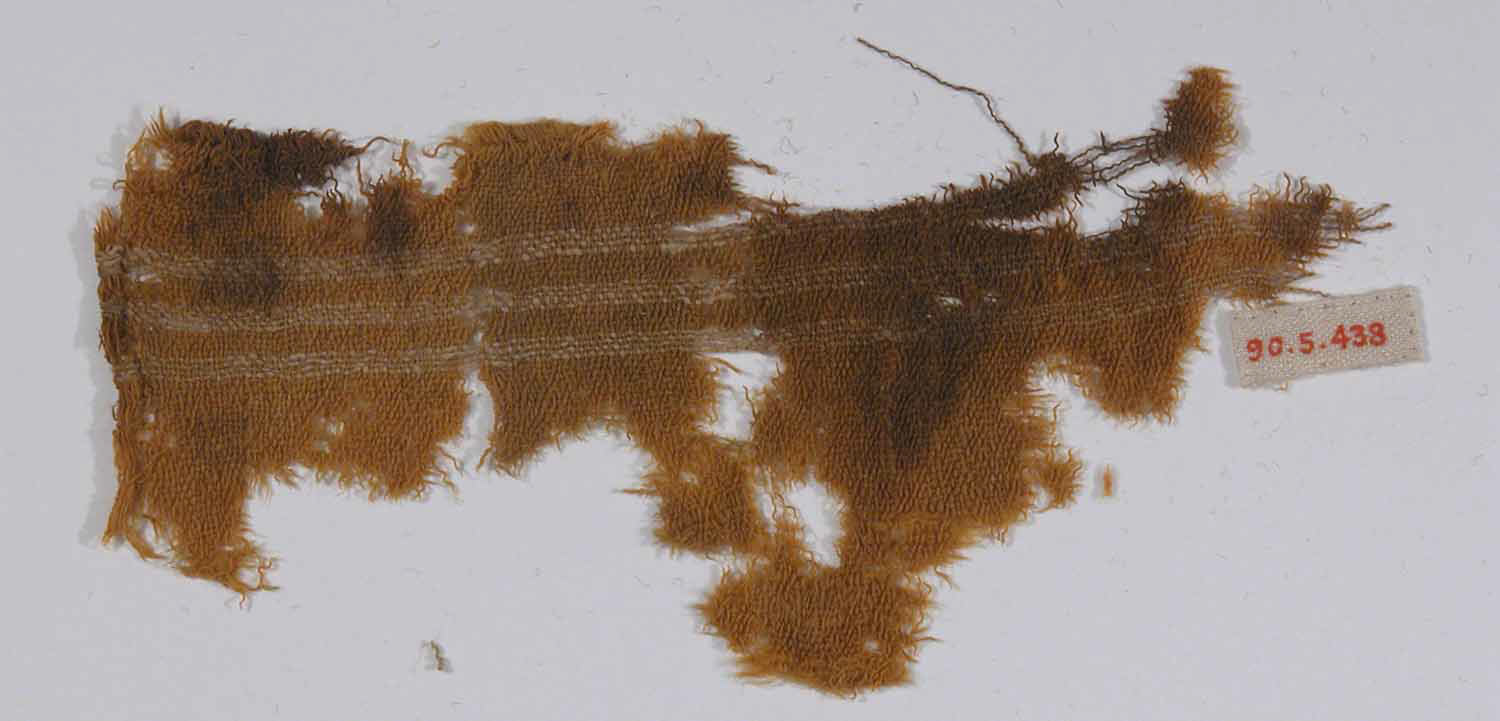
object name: textile fragment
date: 301-500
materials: linen, wool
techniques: weave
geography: egypt